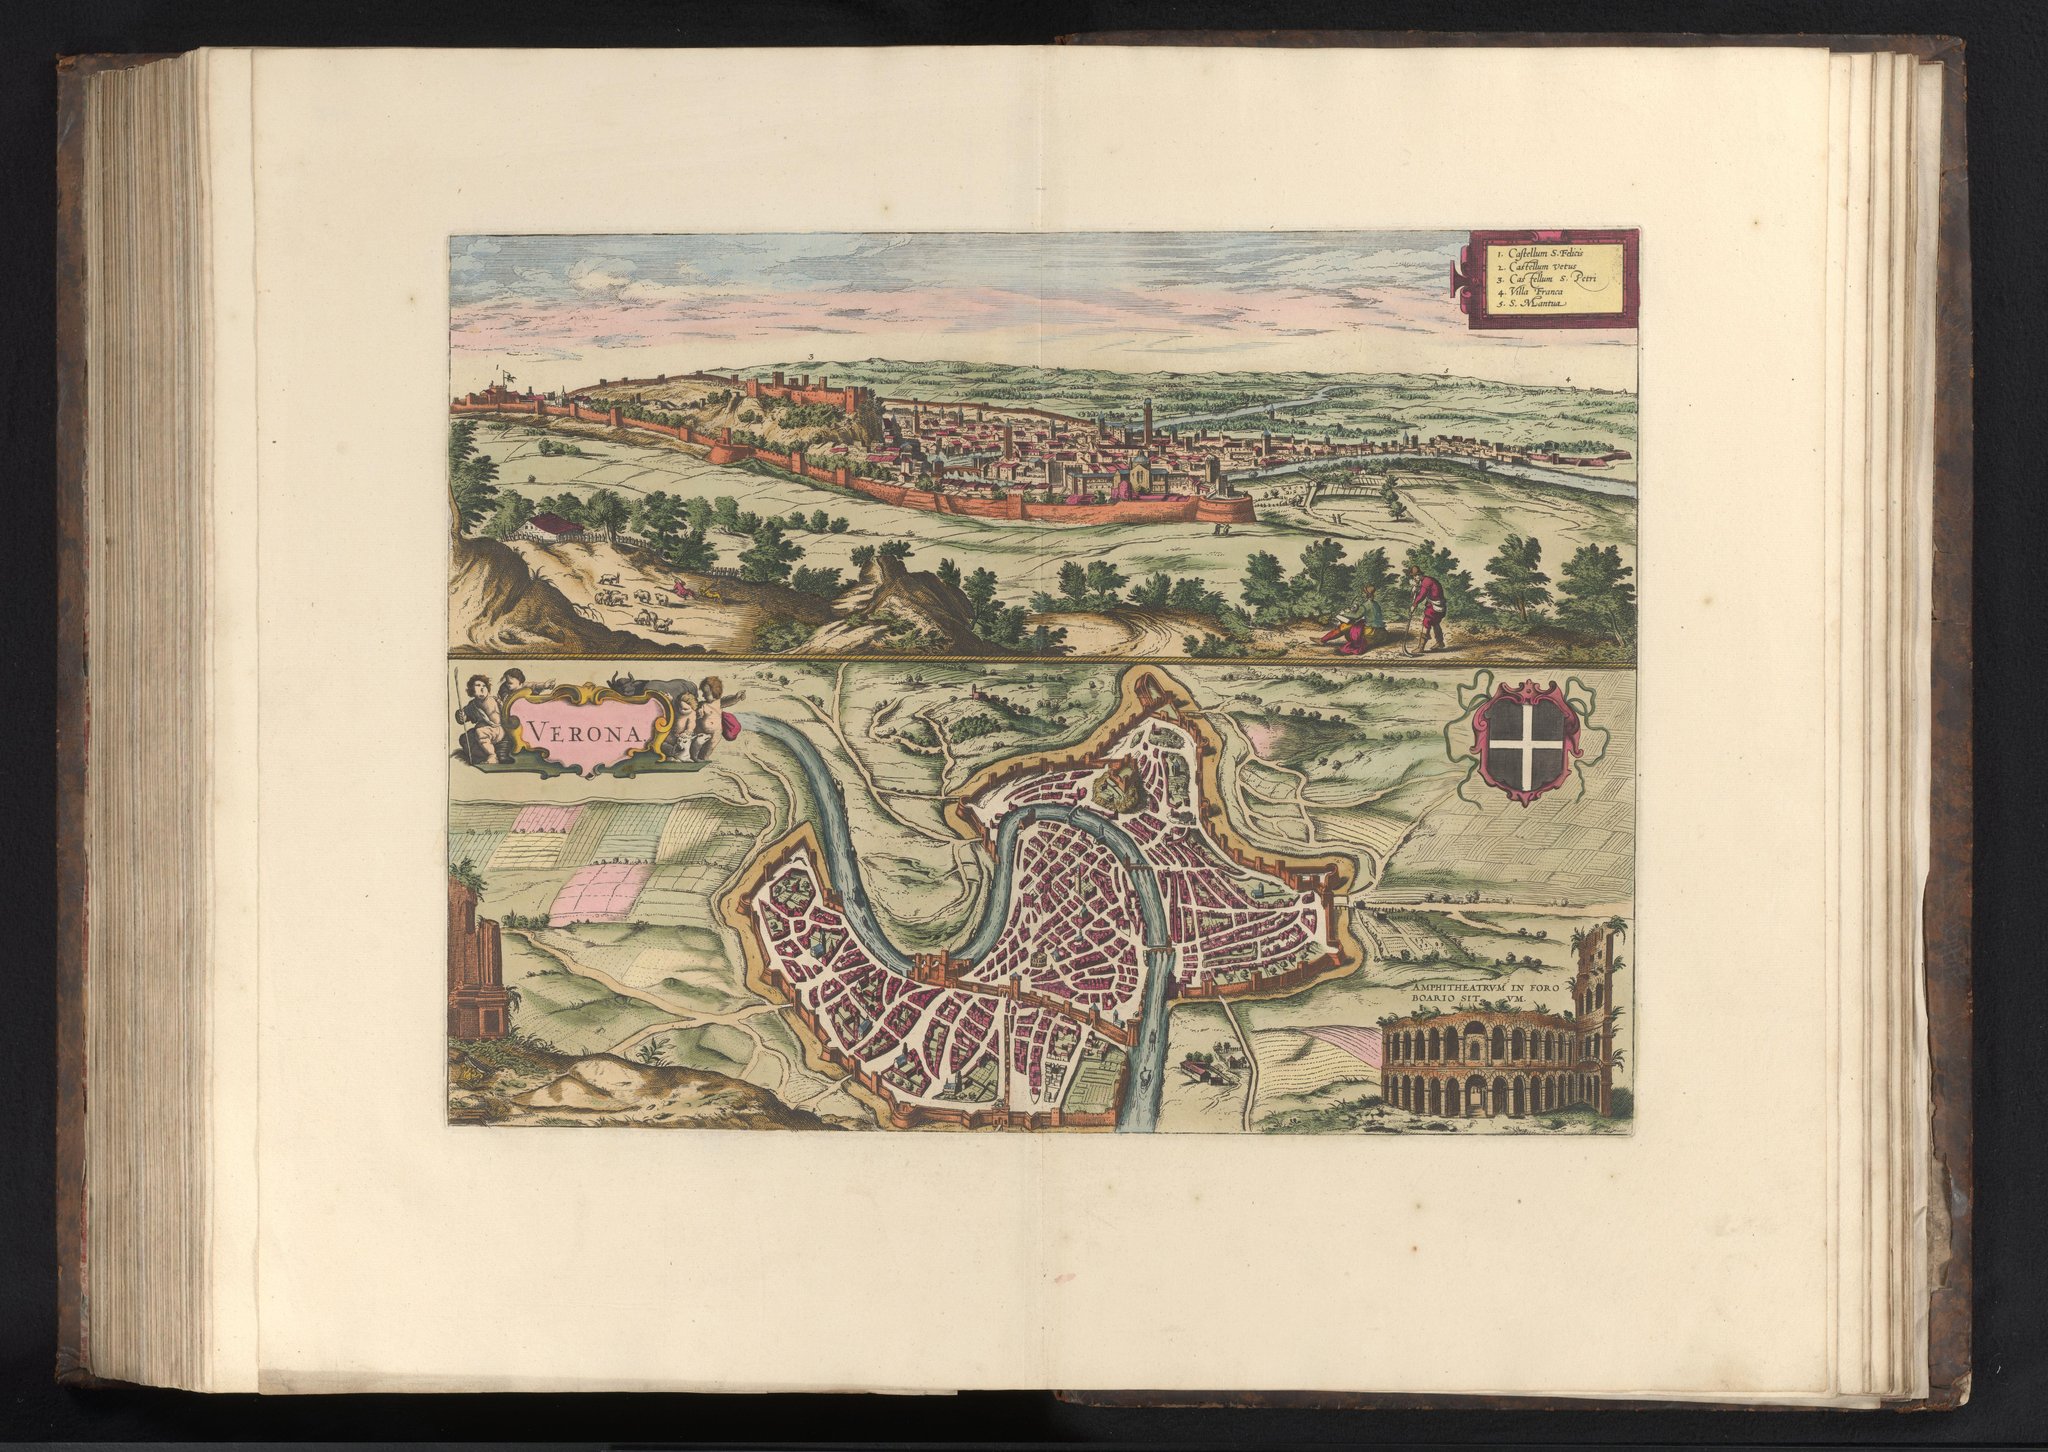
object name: album leaf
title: Gezicht op Verona in vogelvluchtperspectief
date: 1600-1699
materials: paper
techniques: colour, etching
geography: the hague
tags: bird's eye view ~ architectural design or model, maps of cities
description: Boven een gezicht op Verona vanaf de heuvels. Rechtsboven een cartouche met verklarende nummers. Onder een gezicht op Verona in vogelvluchtperspectief. Links een cartouche met titel en vier putti. Rechtsonder een voorstelling van de Arena van Verona. Prent maakt deel uit van een album.